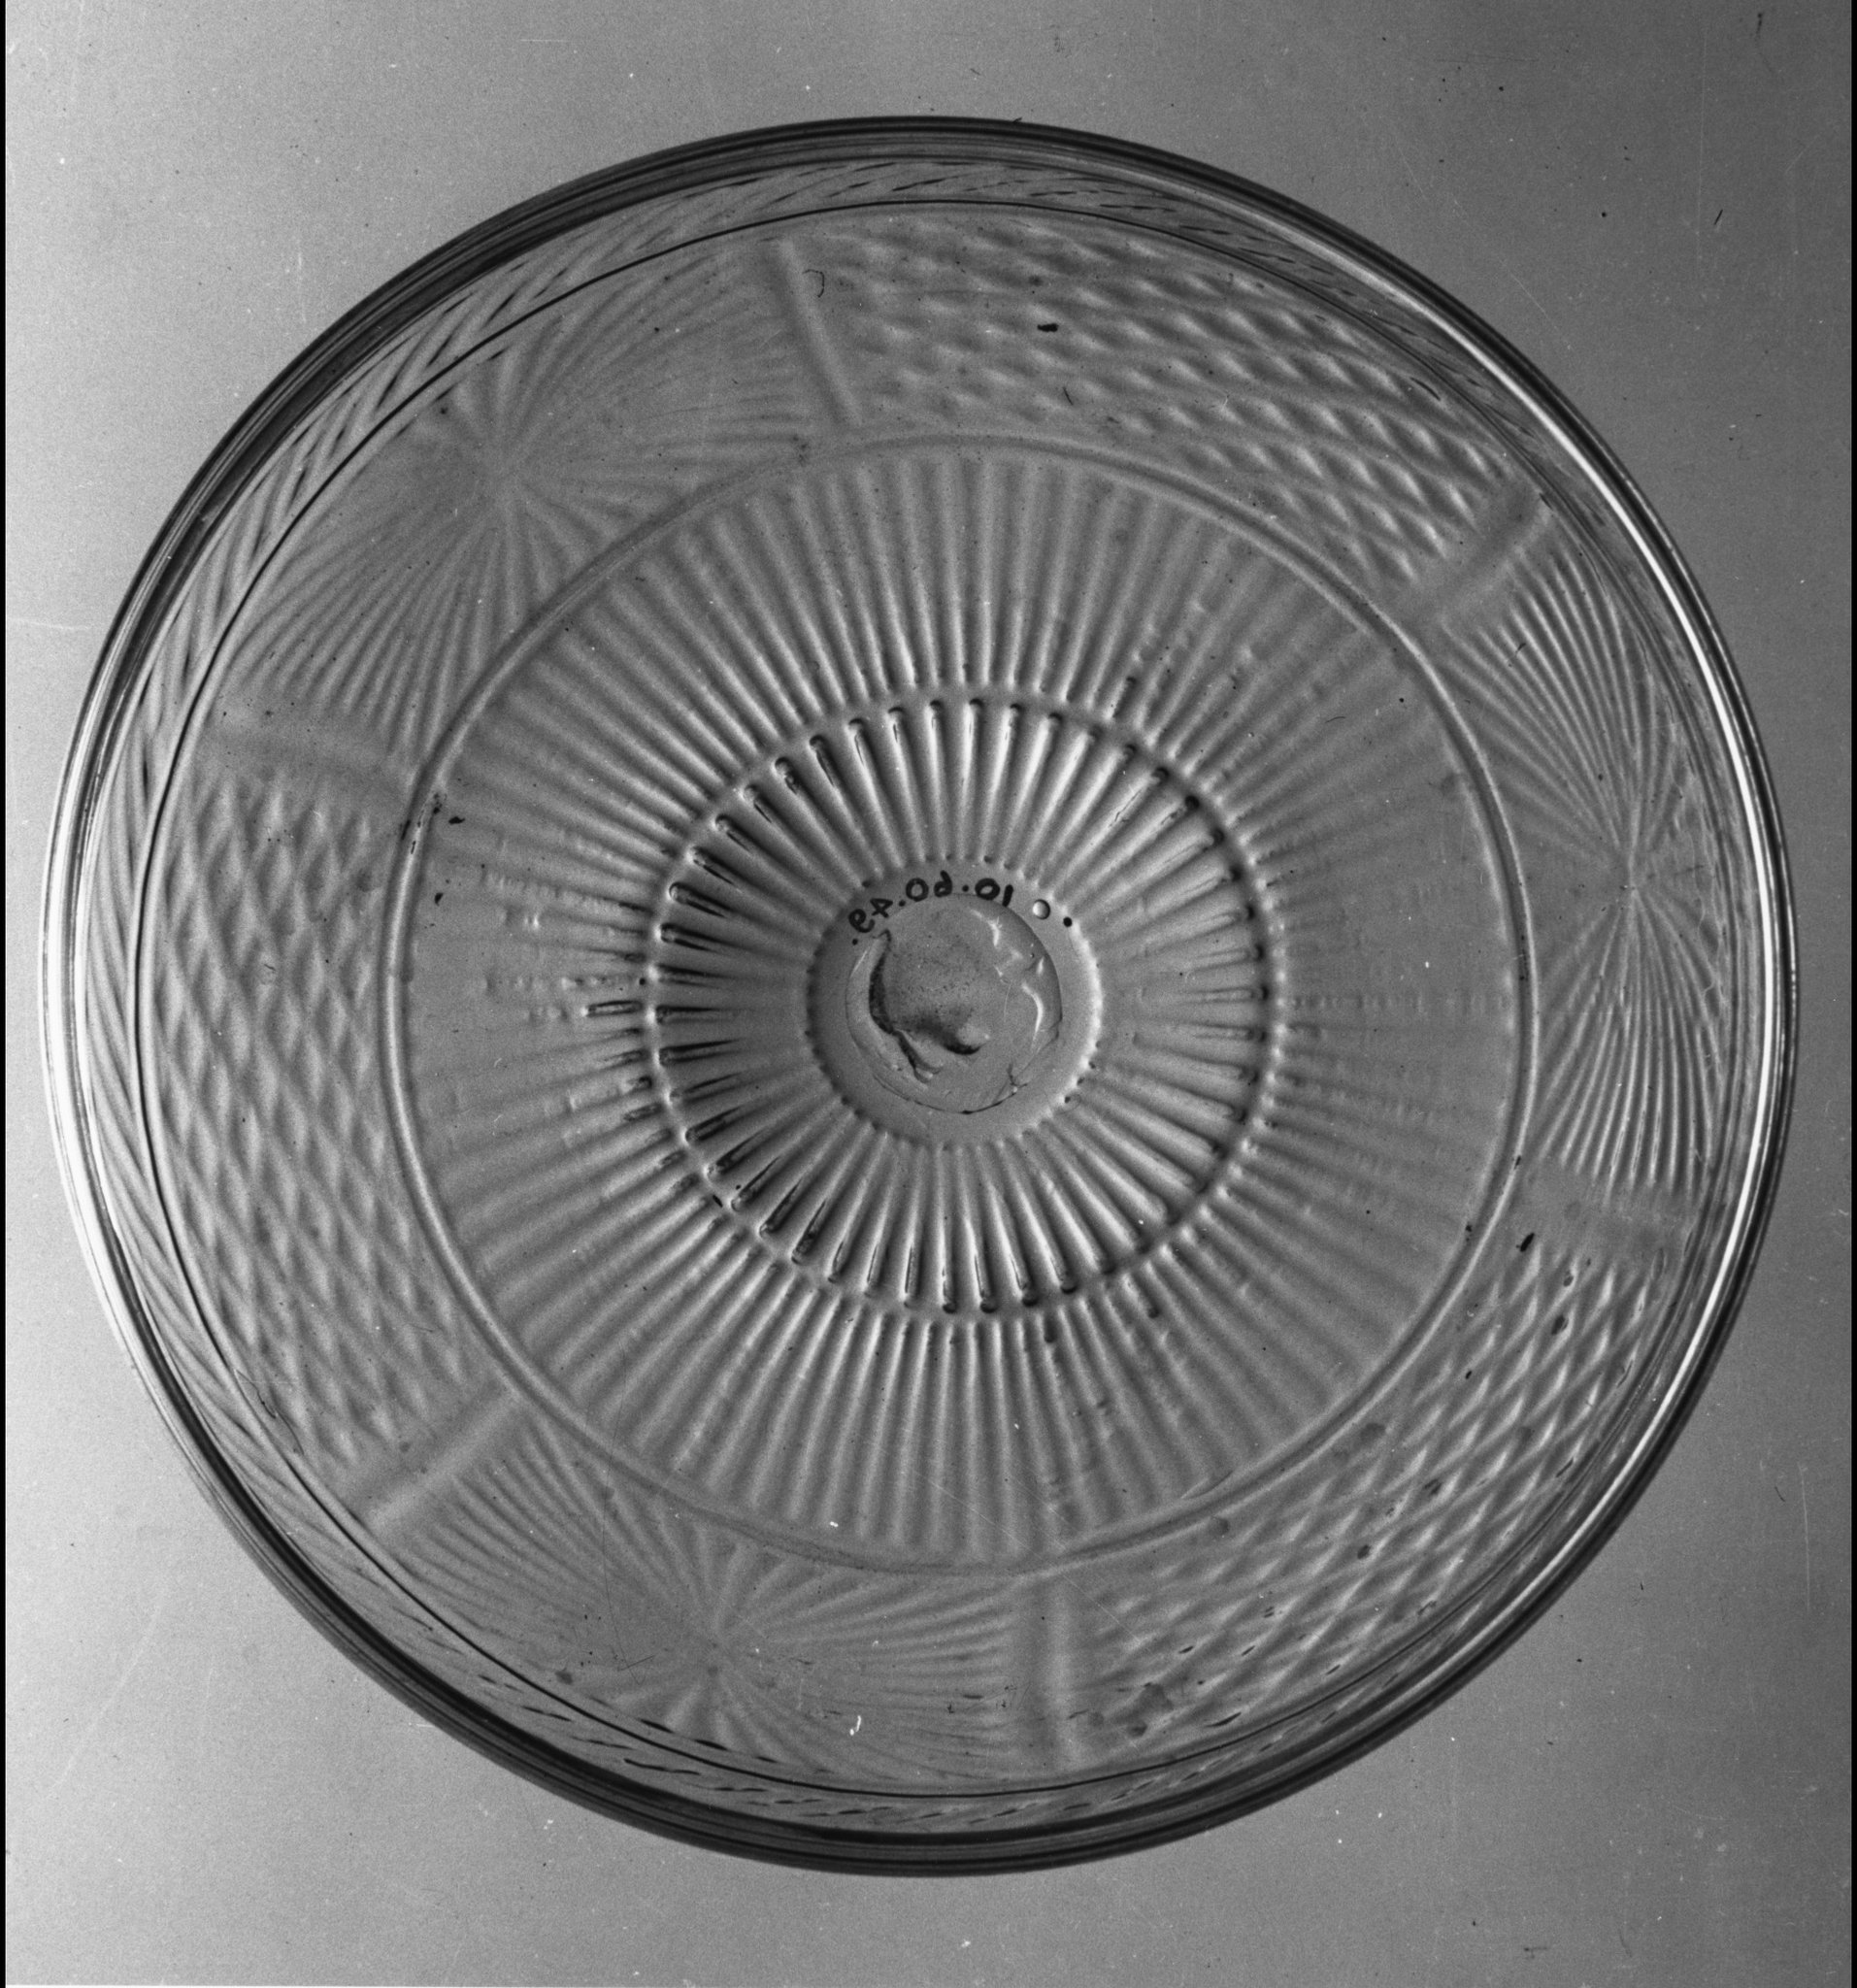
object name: bowl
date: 1820-1840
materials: glass, lead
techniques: glassblowing, molding